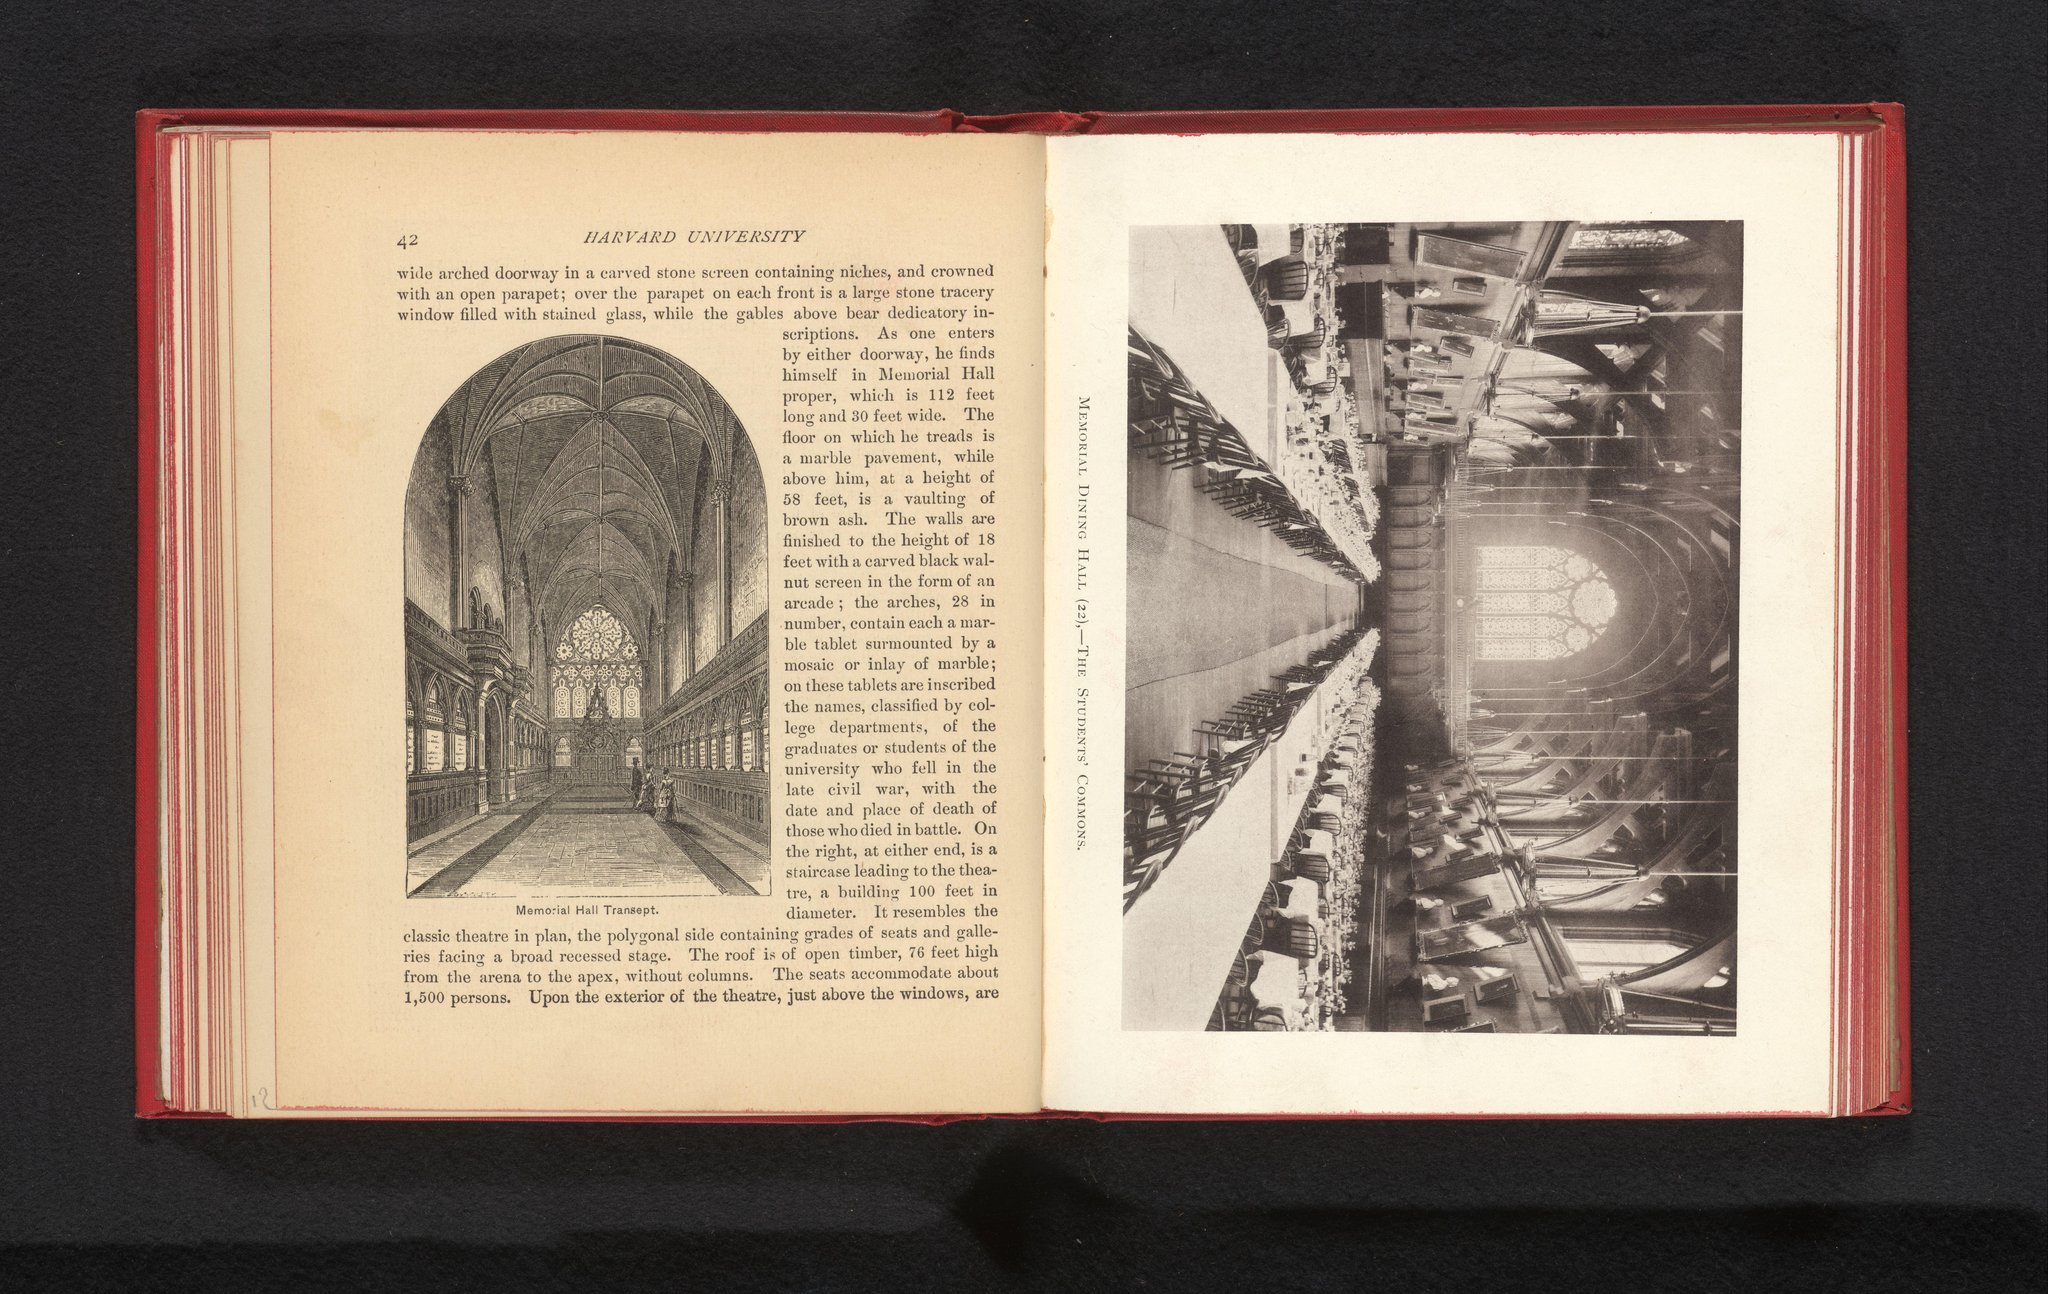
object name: page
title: Memorial Dining Hall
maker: Anonymous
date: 1881-1886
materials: paper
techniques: photograph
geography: cambridge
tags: university building, college, interior ~ representation of a building, dining-room